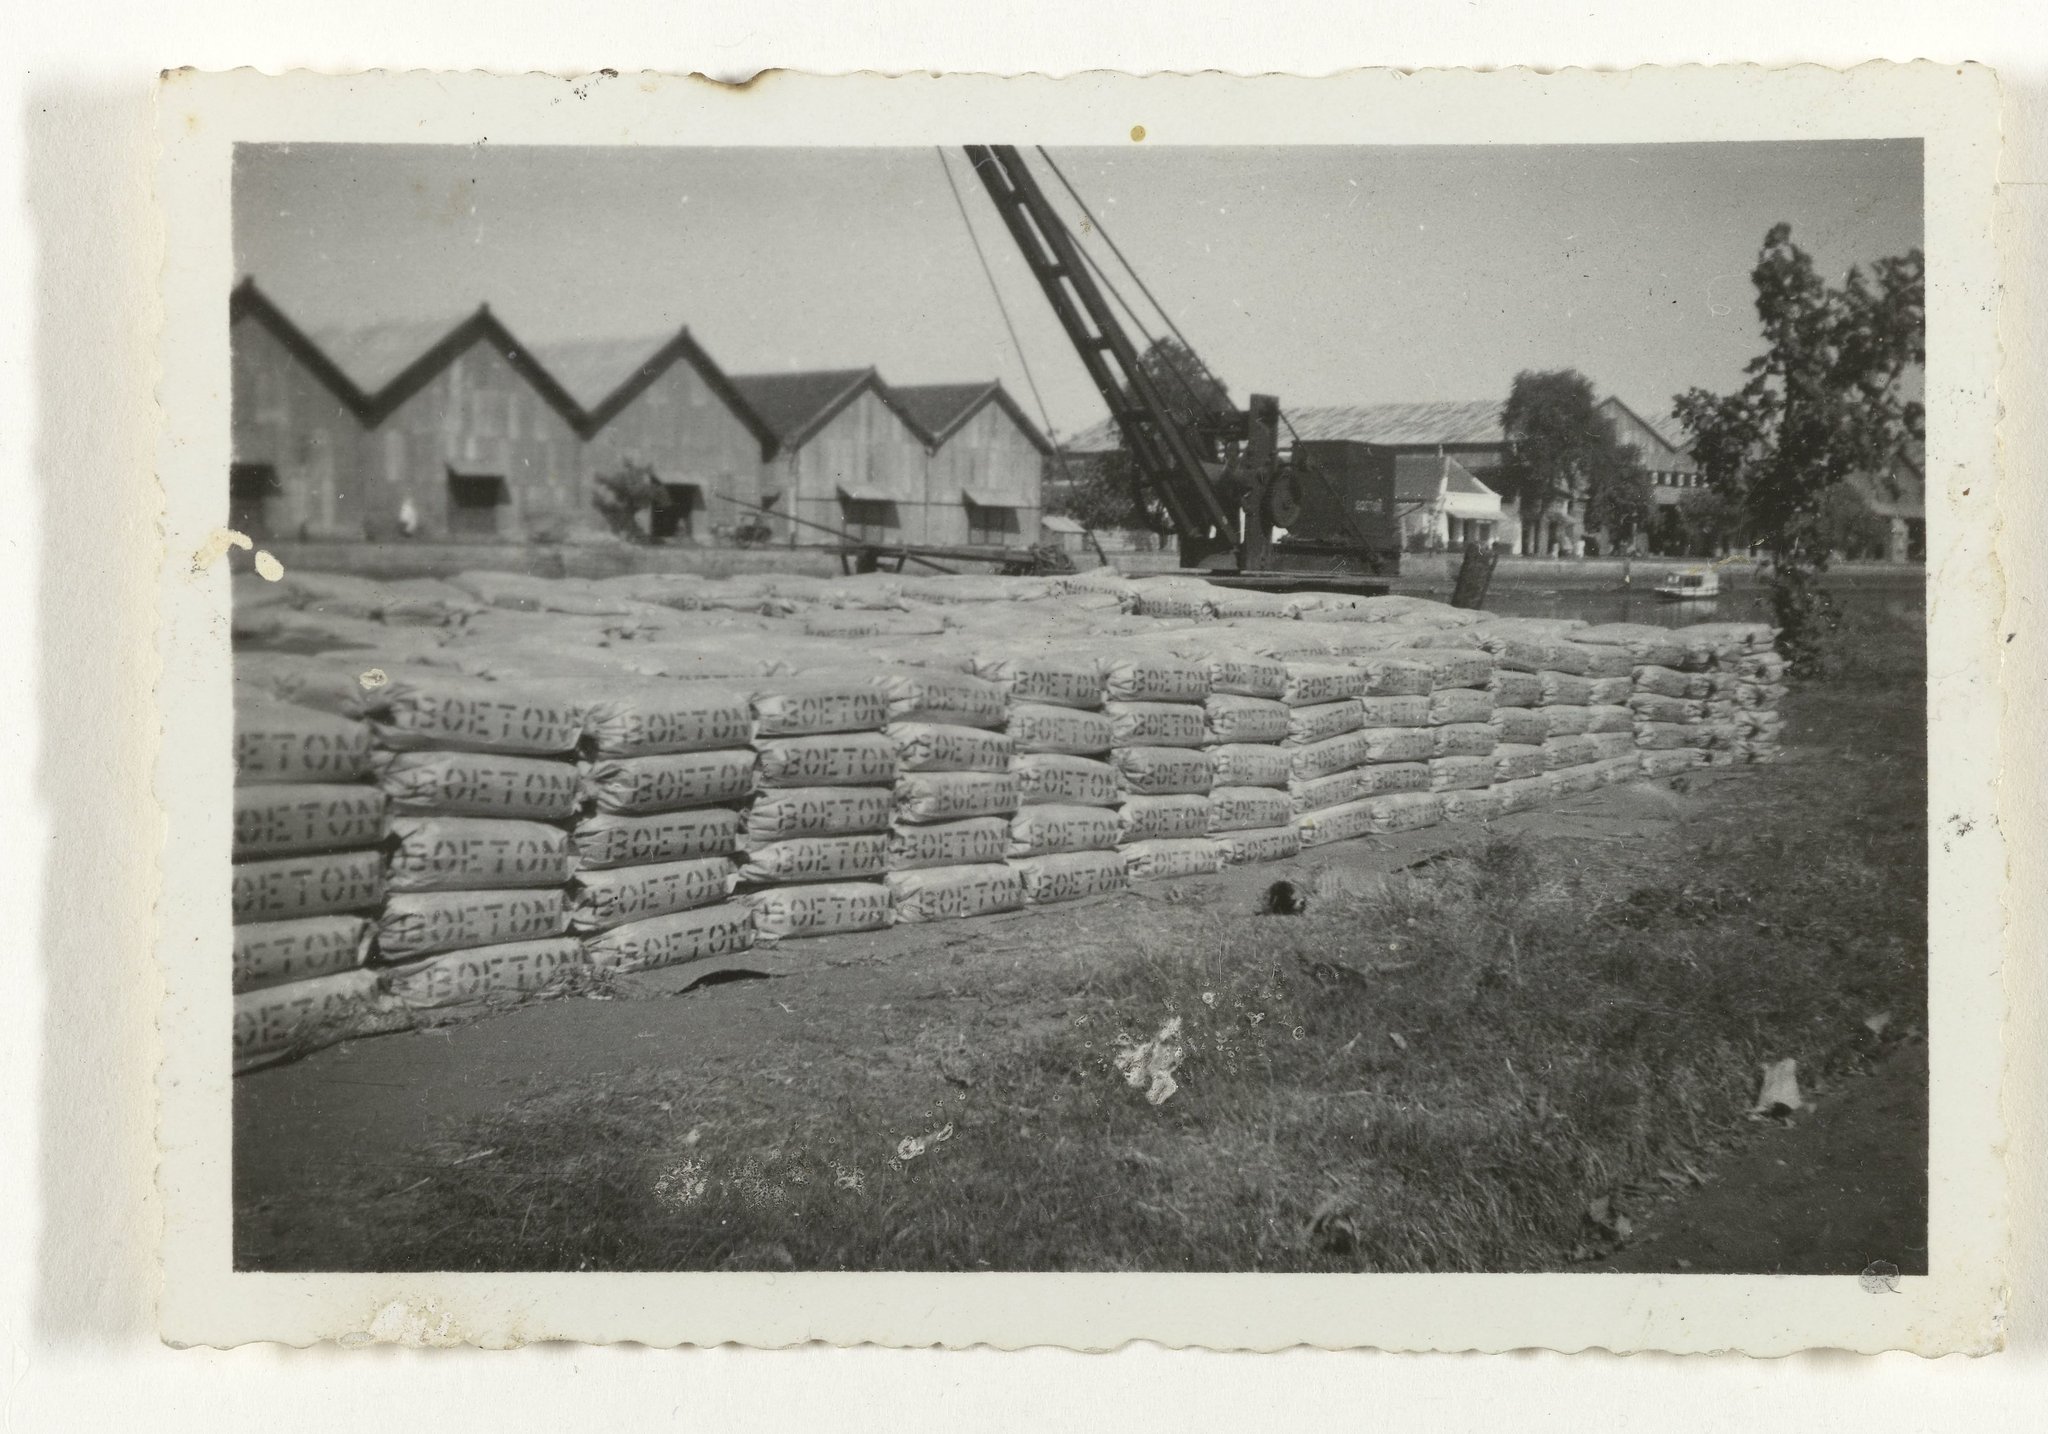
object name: photograph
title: Mijnbouwmaatschappij Boeton op Celebes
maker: Anonymous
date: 1930-1947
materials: photographic support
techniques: gelatin silver print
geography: celebes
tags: r.h. vonk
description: Opslagplaats van de NV Mijnbouw-Maatschappij "Boeton" op Celebes, gesticht in 1926. Zakken met delfstoffen klaar om verscheept te worden. Onderdeel van een groep losse foto's behorend bij de familiealbums van de familie Vonk op Zuid-Celebes.